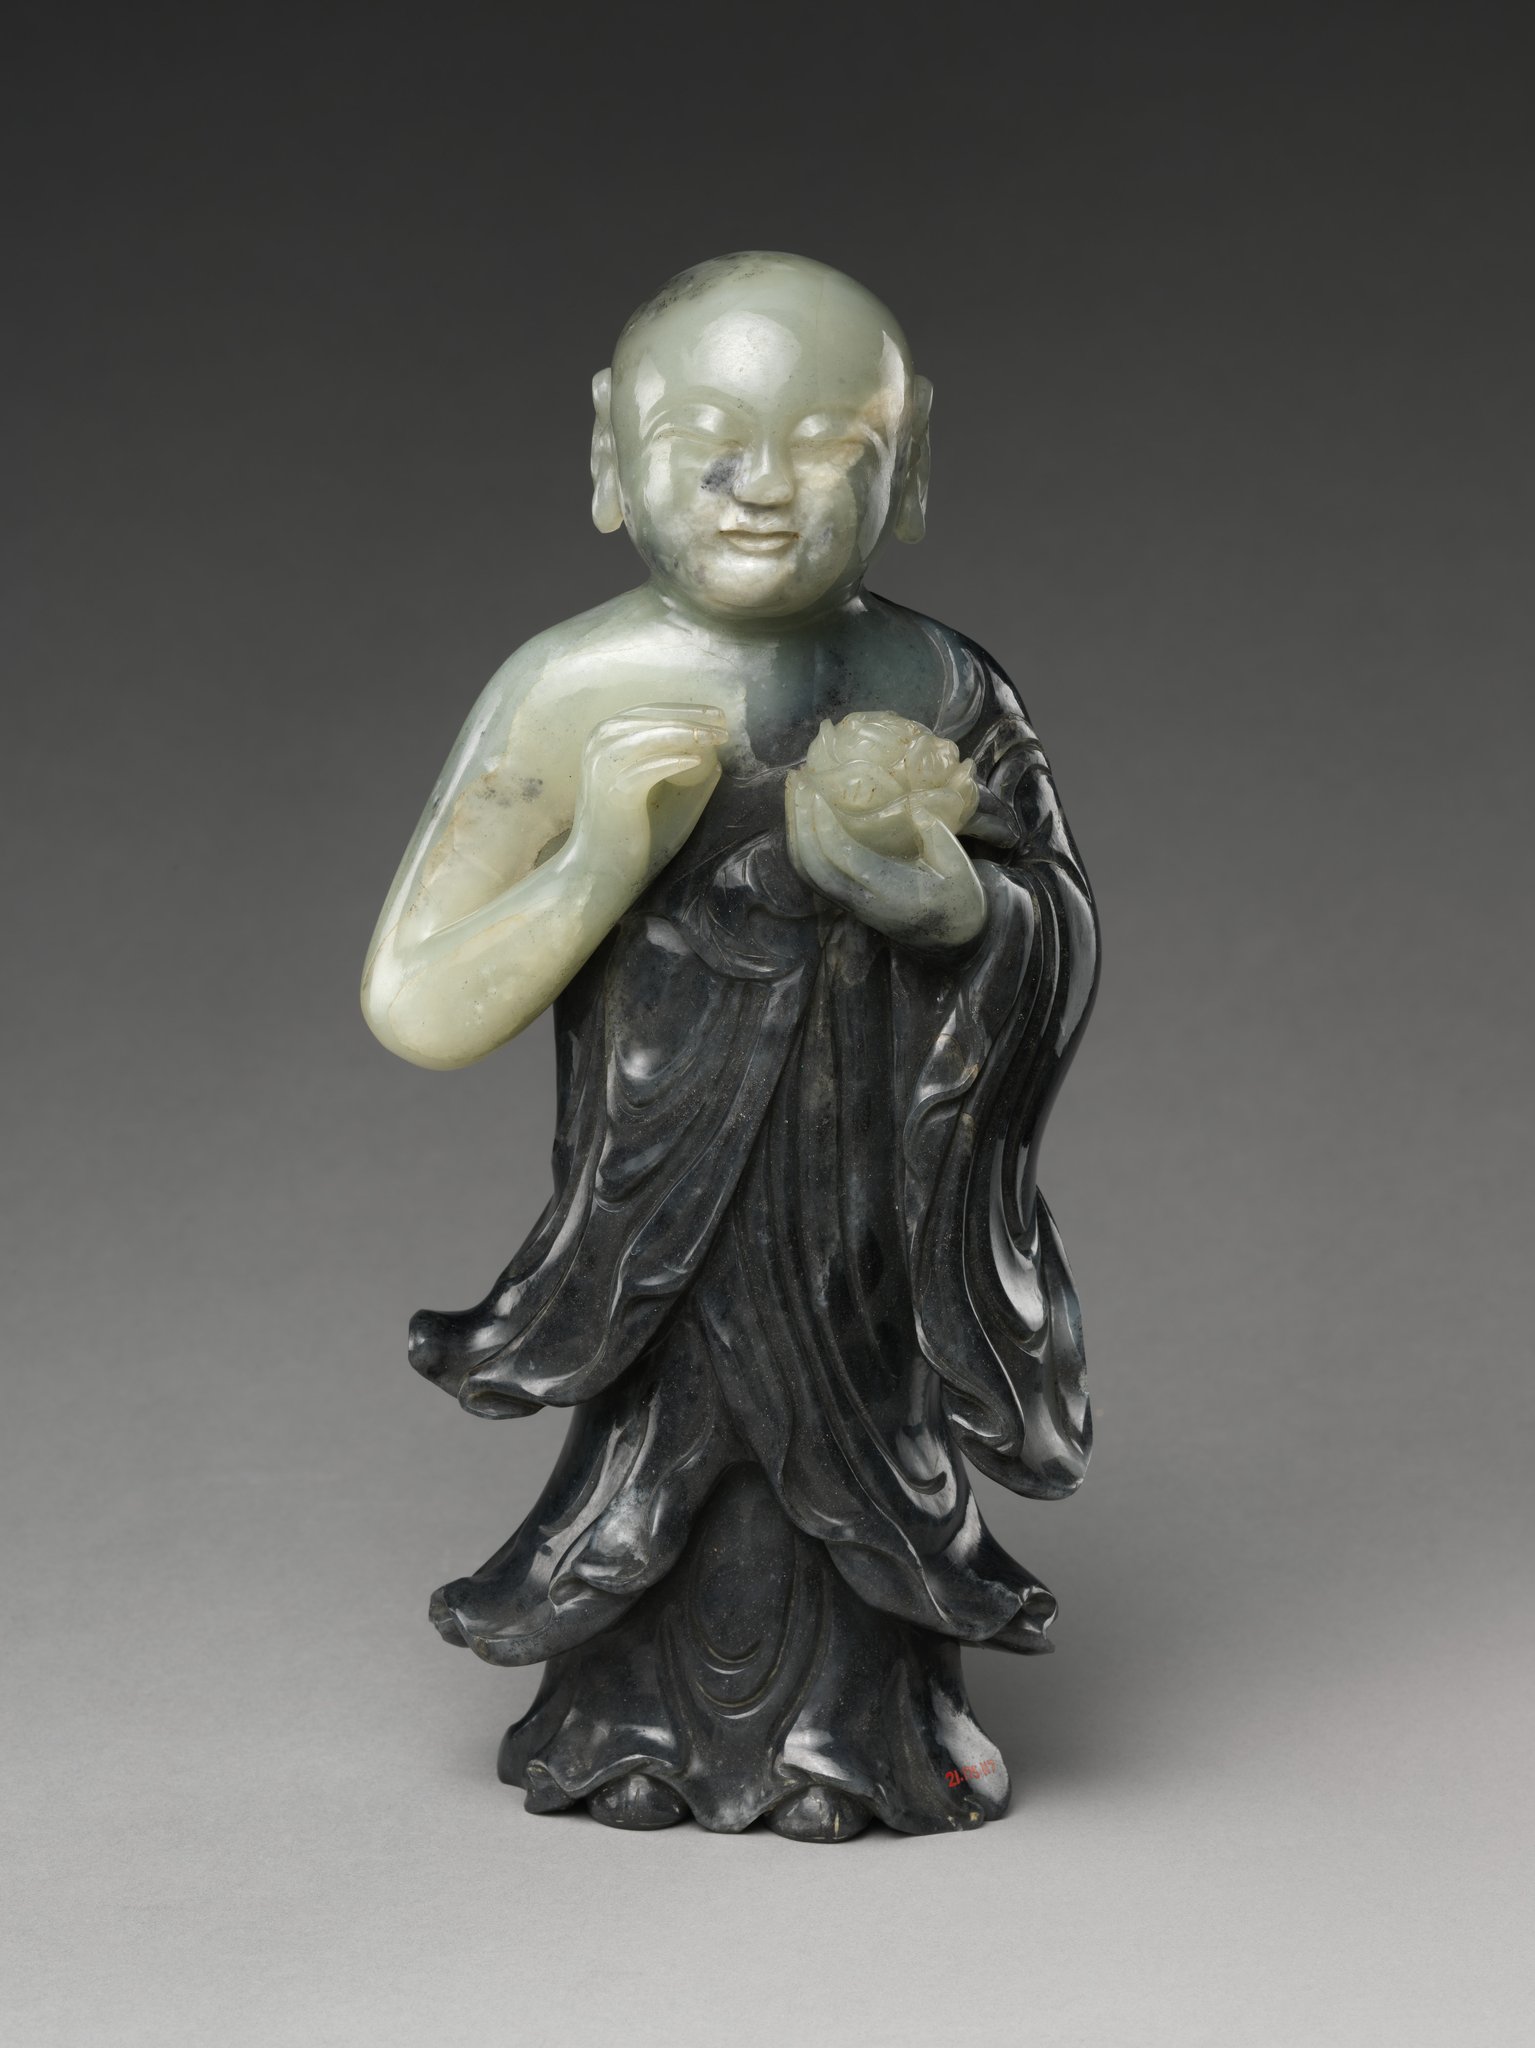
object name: figure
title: Arhat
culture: chinese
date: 1701-1900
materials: jade